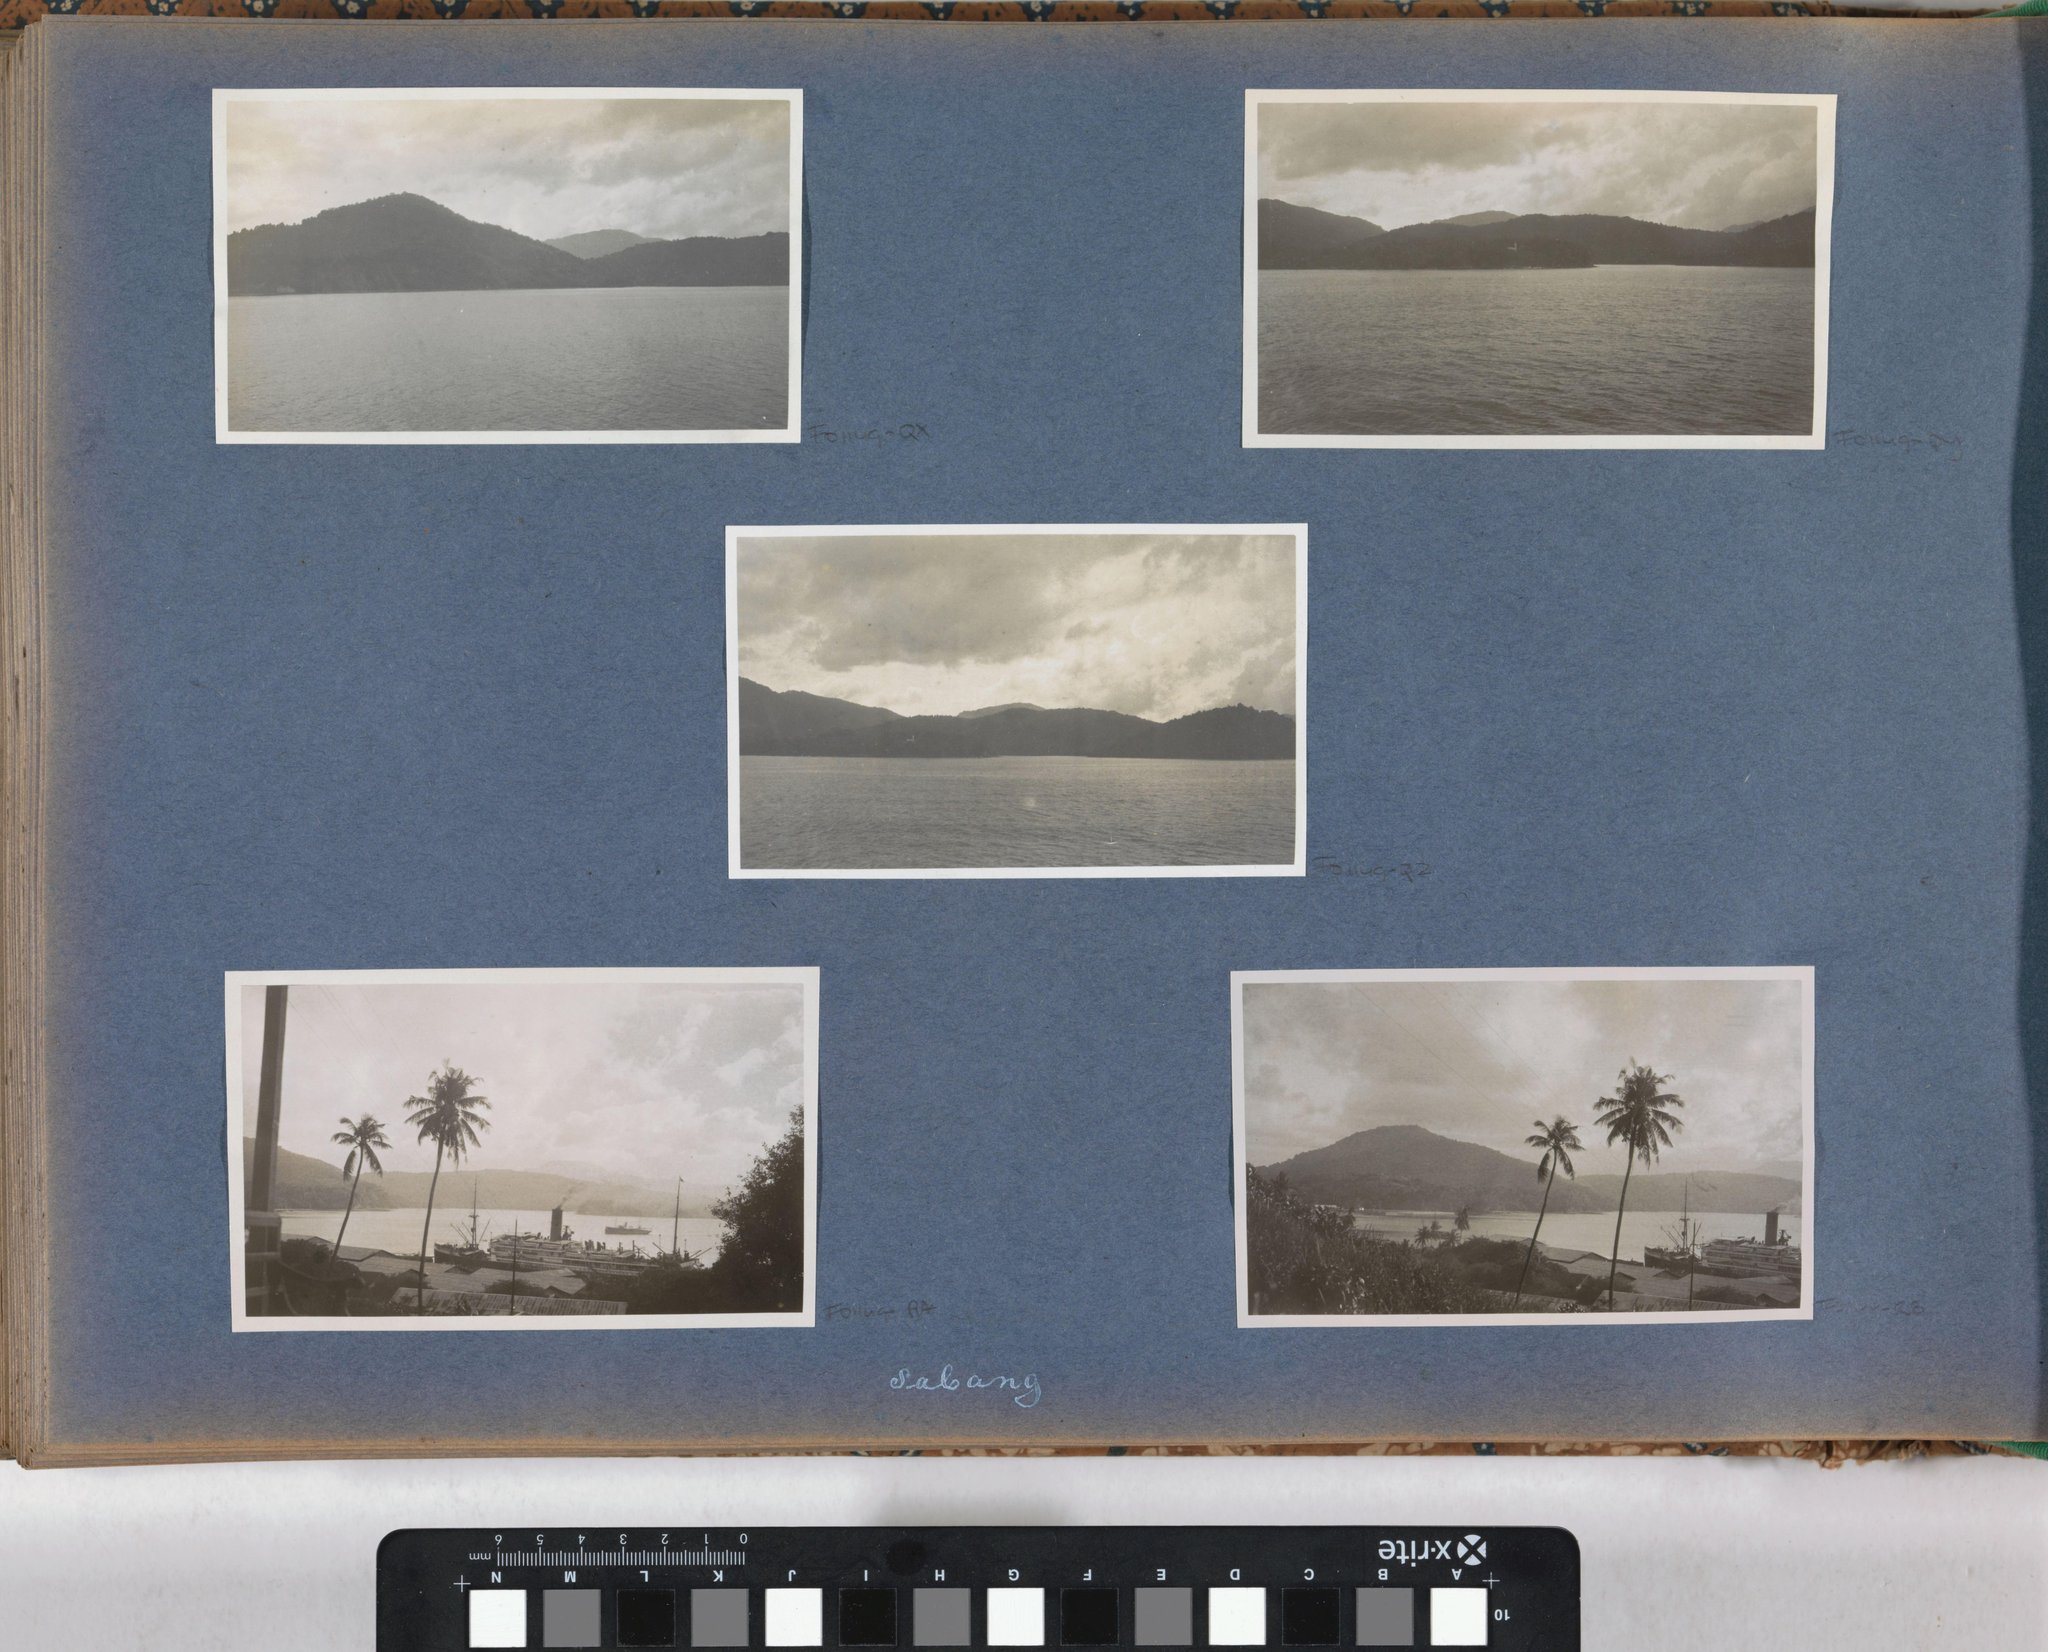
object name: photograph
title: Meer met bergen te Sabang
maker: Anonymous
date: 1900-1920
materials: paper, photographic support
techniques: gelatin silver print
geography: sabang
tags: lake, mountains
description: Onderdeel van reisalbum met foto's van bedrijvigheid en bezienswaardigheden op Sumatra en Java en van de reis naar en van Nederlands-Indië.